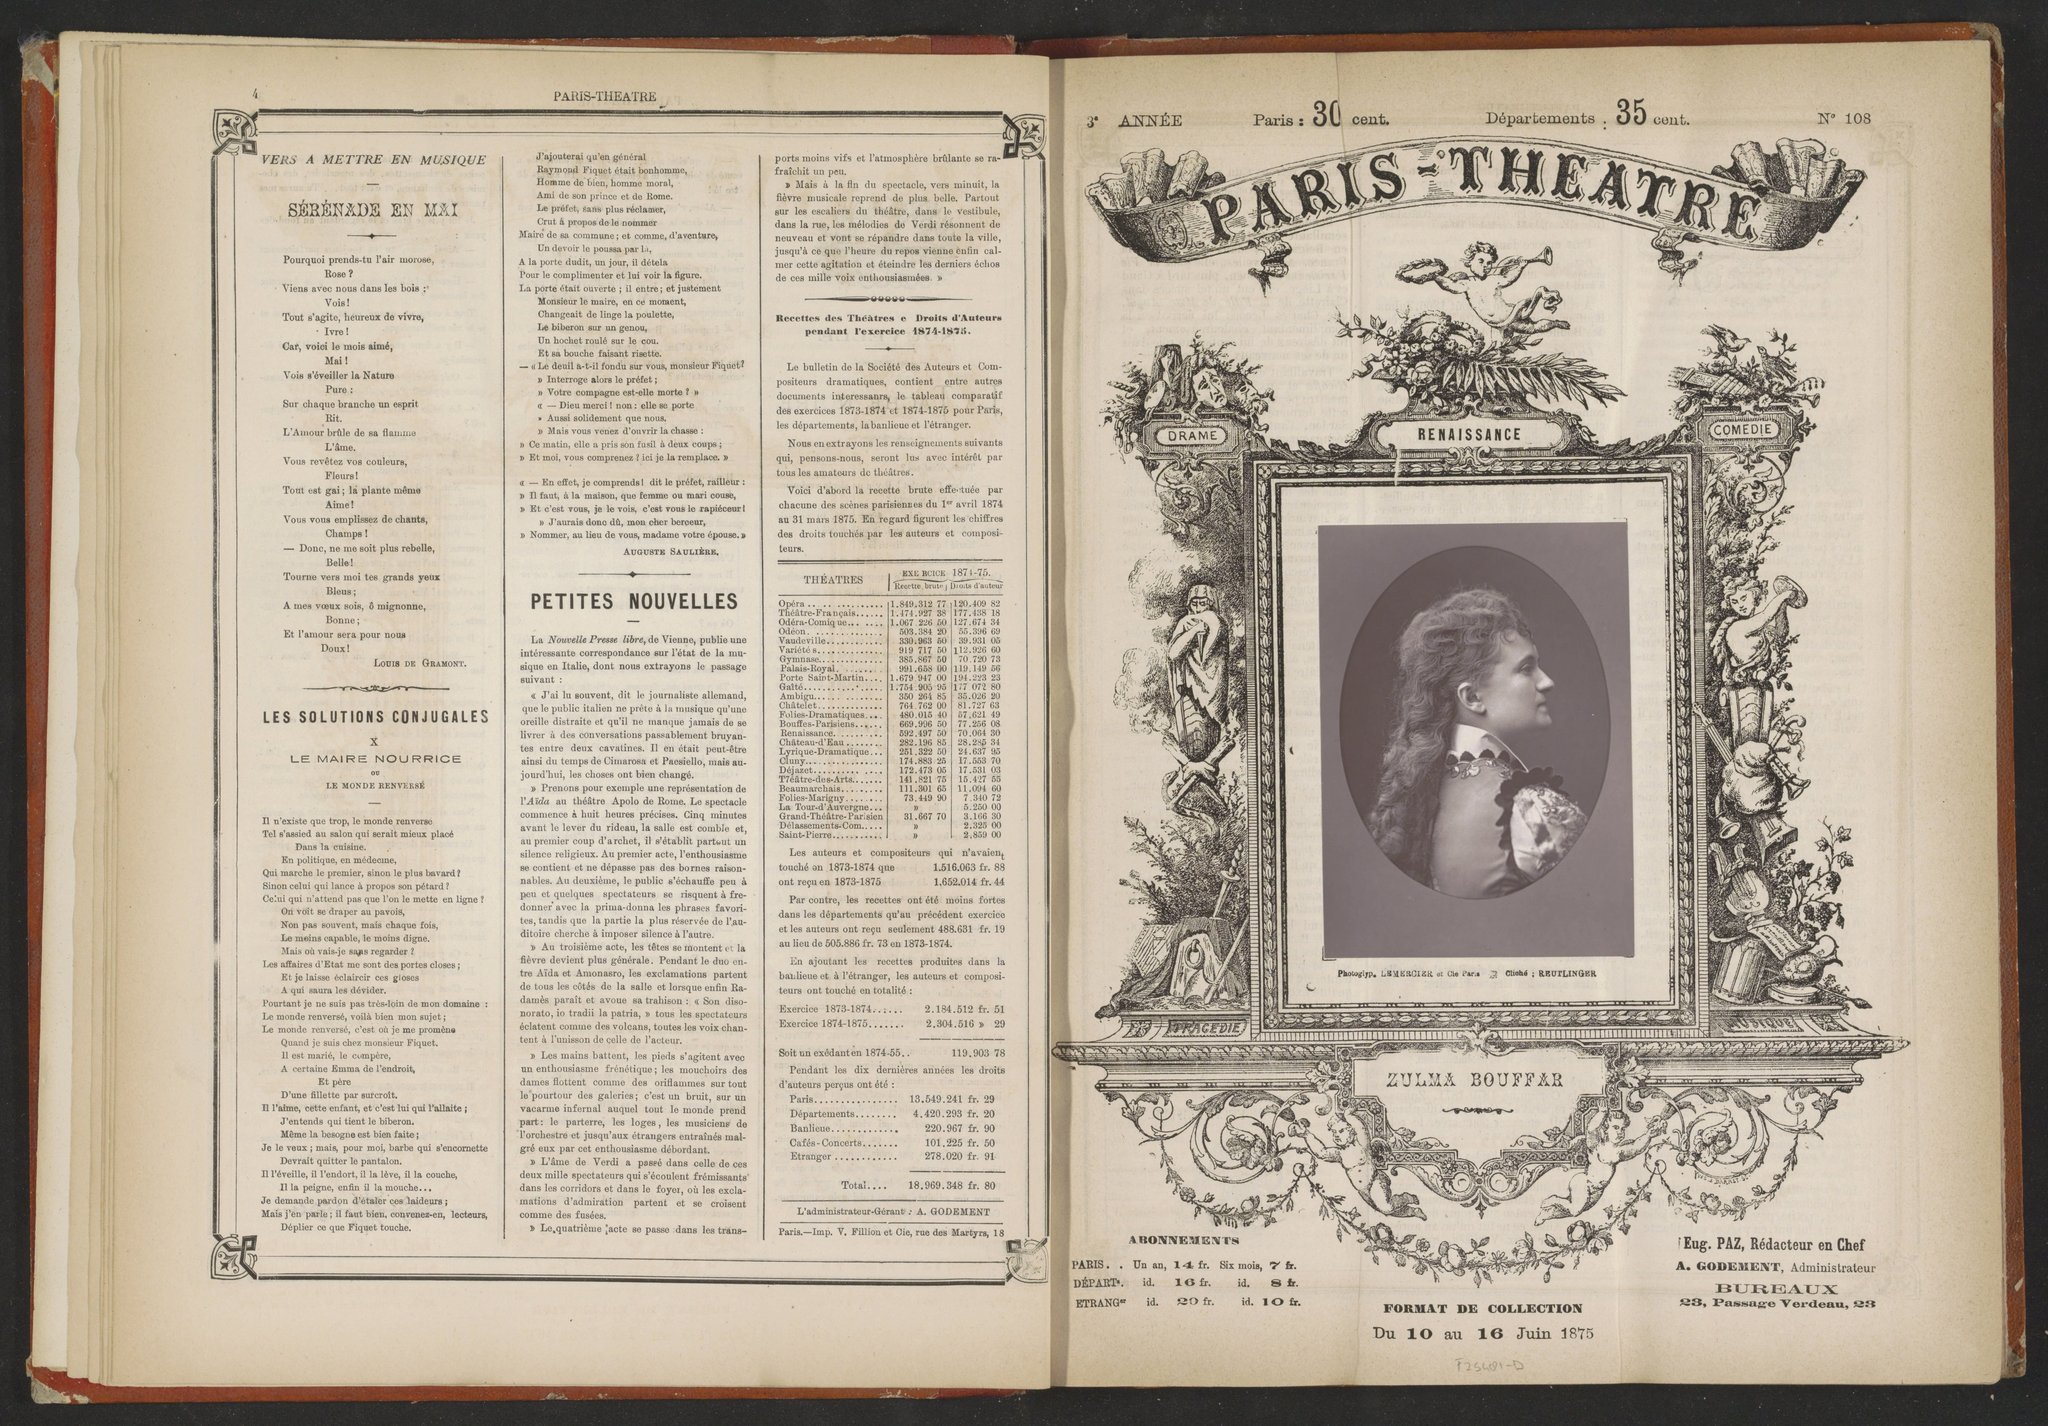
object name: page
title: Portret van Zulma Bouffar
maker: charles reutlinger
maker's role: publisher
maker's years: 1816-1880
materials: paper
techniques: woodburytype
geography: paris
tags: zangeres, zulma bouffar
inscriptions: number: ‘No 108’, inscription: ‘Du 10 au 16 Juin 1875’